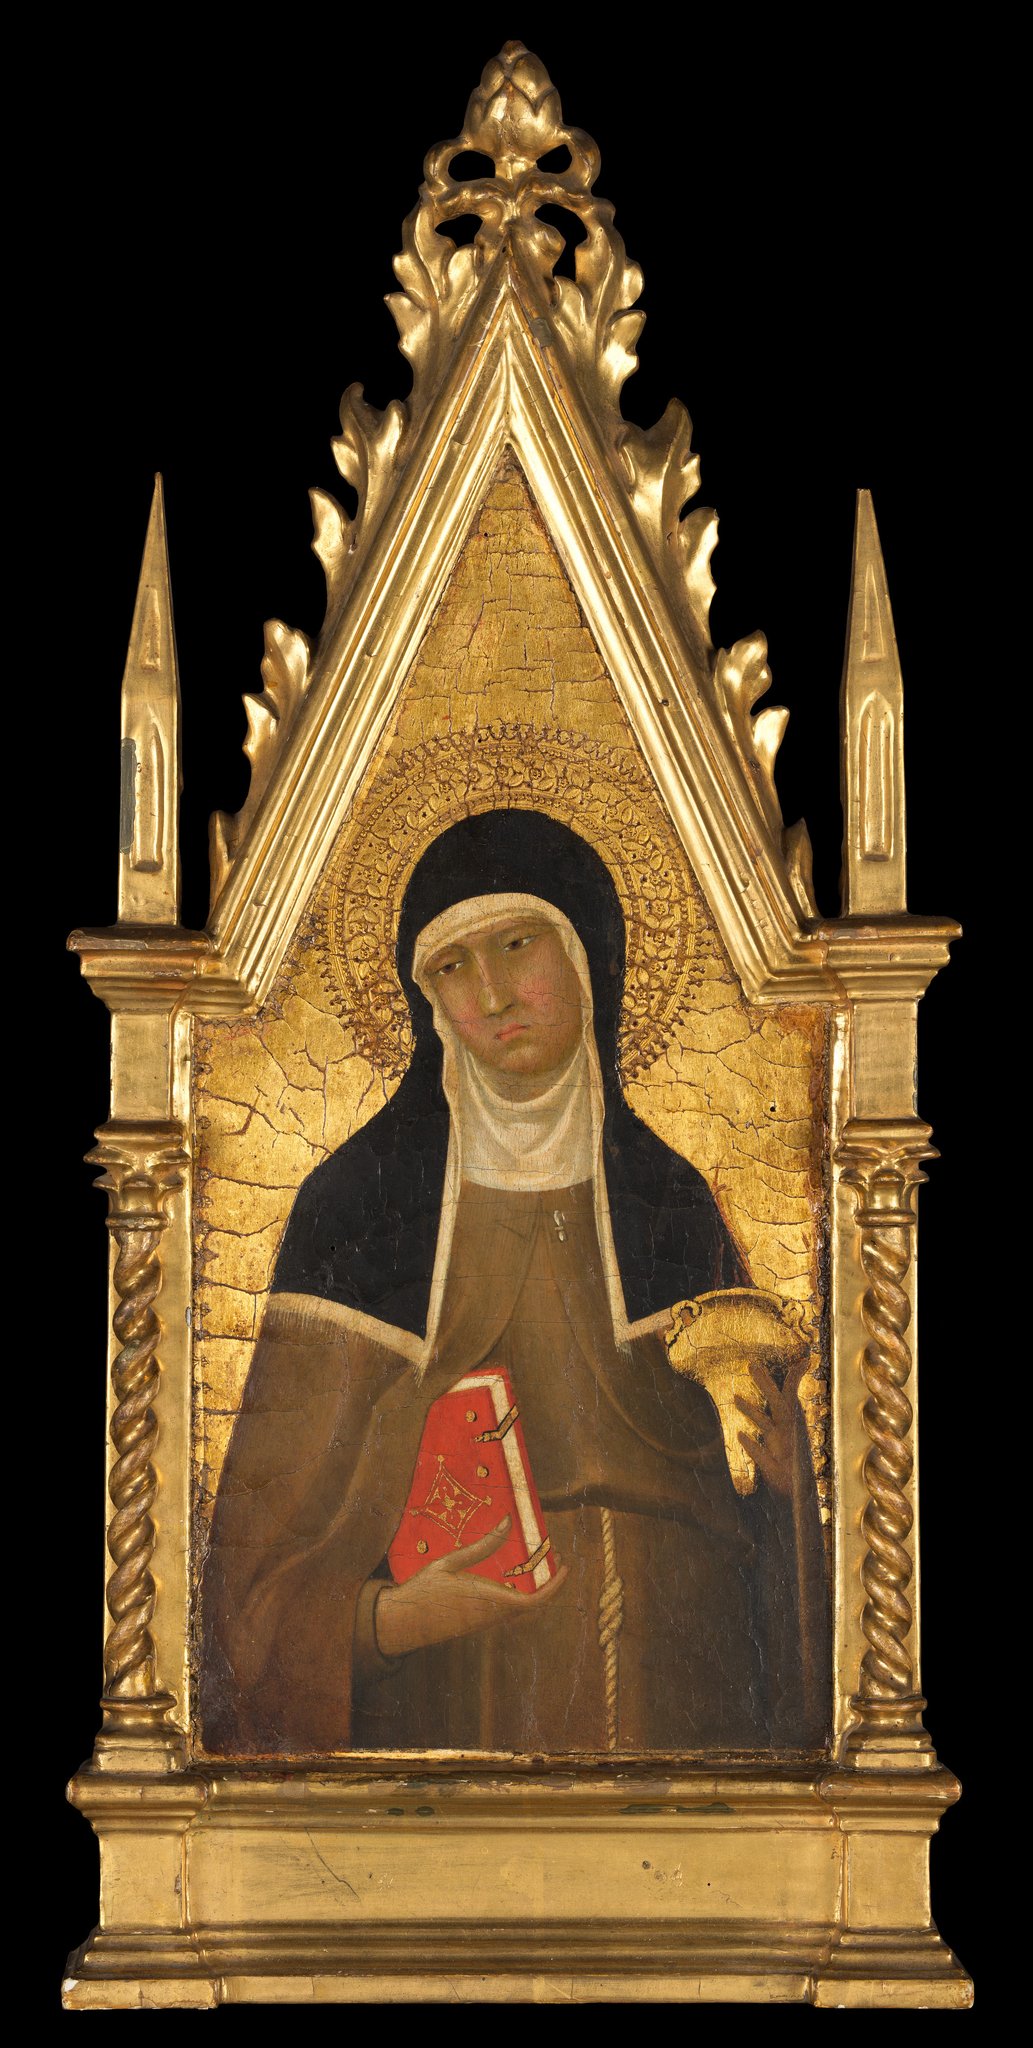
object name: painting, part of an altarpiece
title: Saint Clare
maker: lippo memmi (filippo di memmo)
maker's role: artist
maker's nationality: italian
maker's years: 1317-1356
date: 1330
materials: gold leaf, paint, wood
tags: books,women,saints